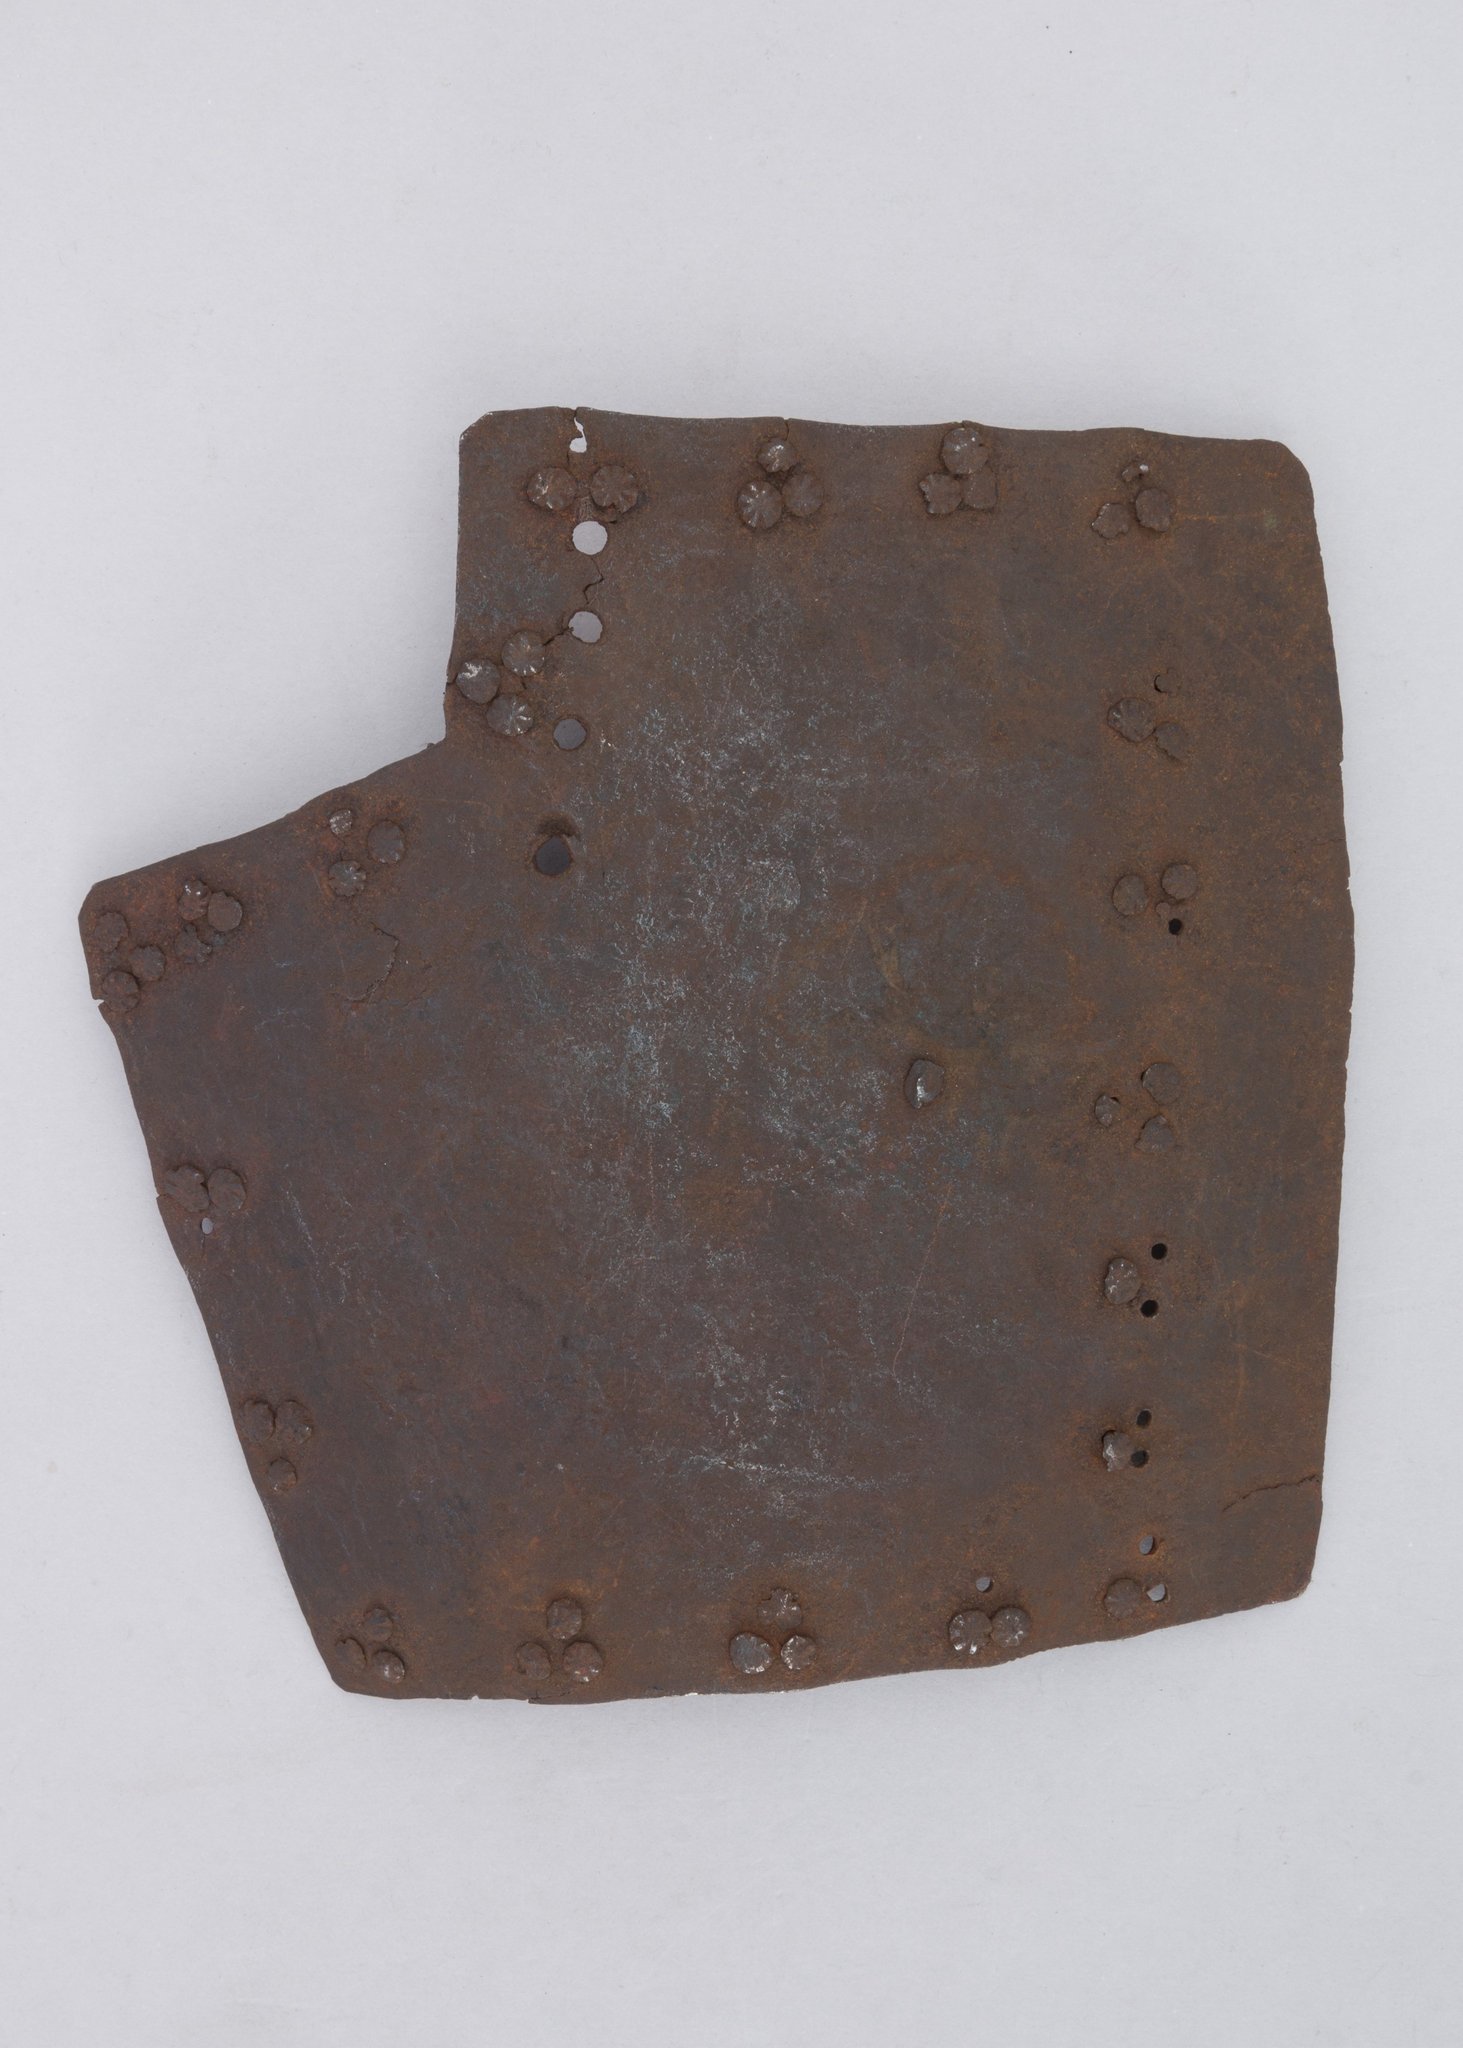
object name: brigandine plate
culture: italian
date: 1400-1450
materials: metal alloy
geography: italy